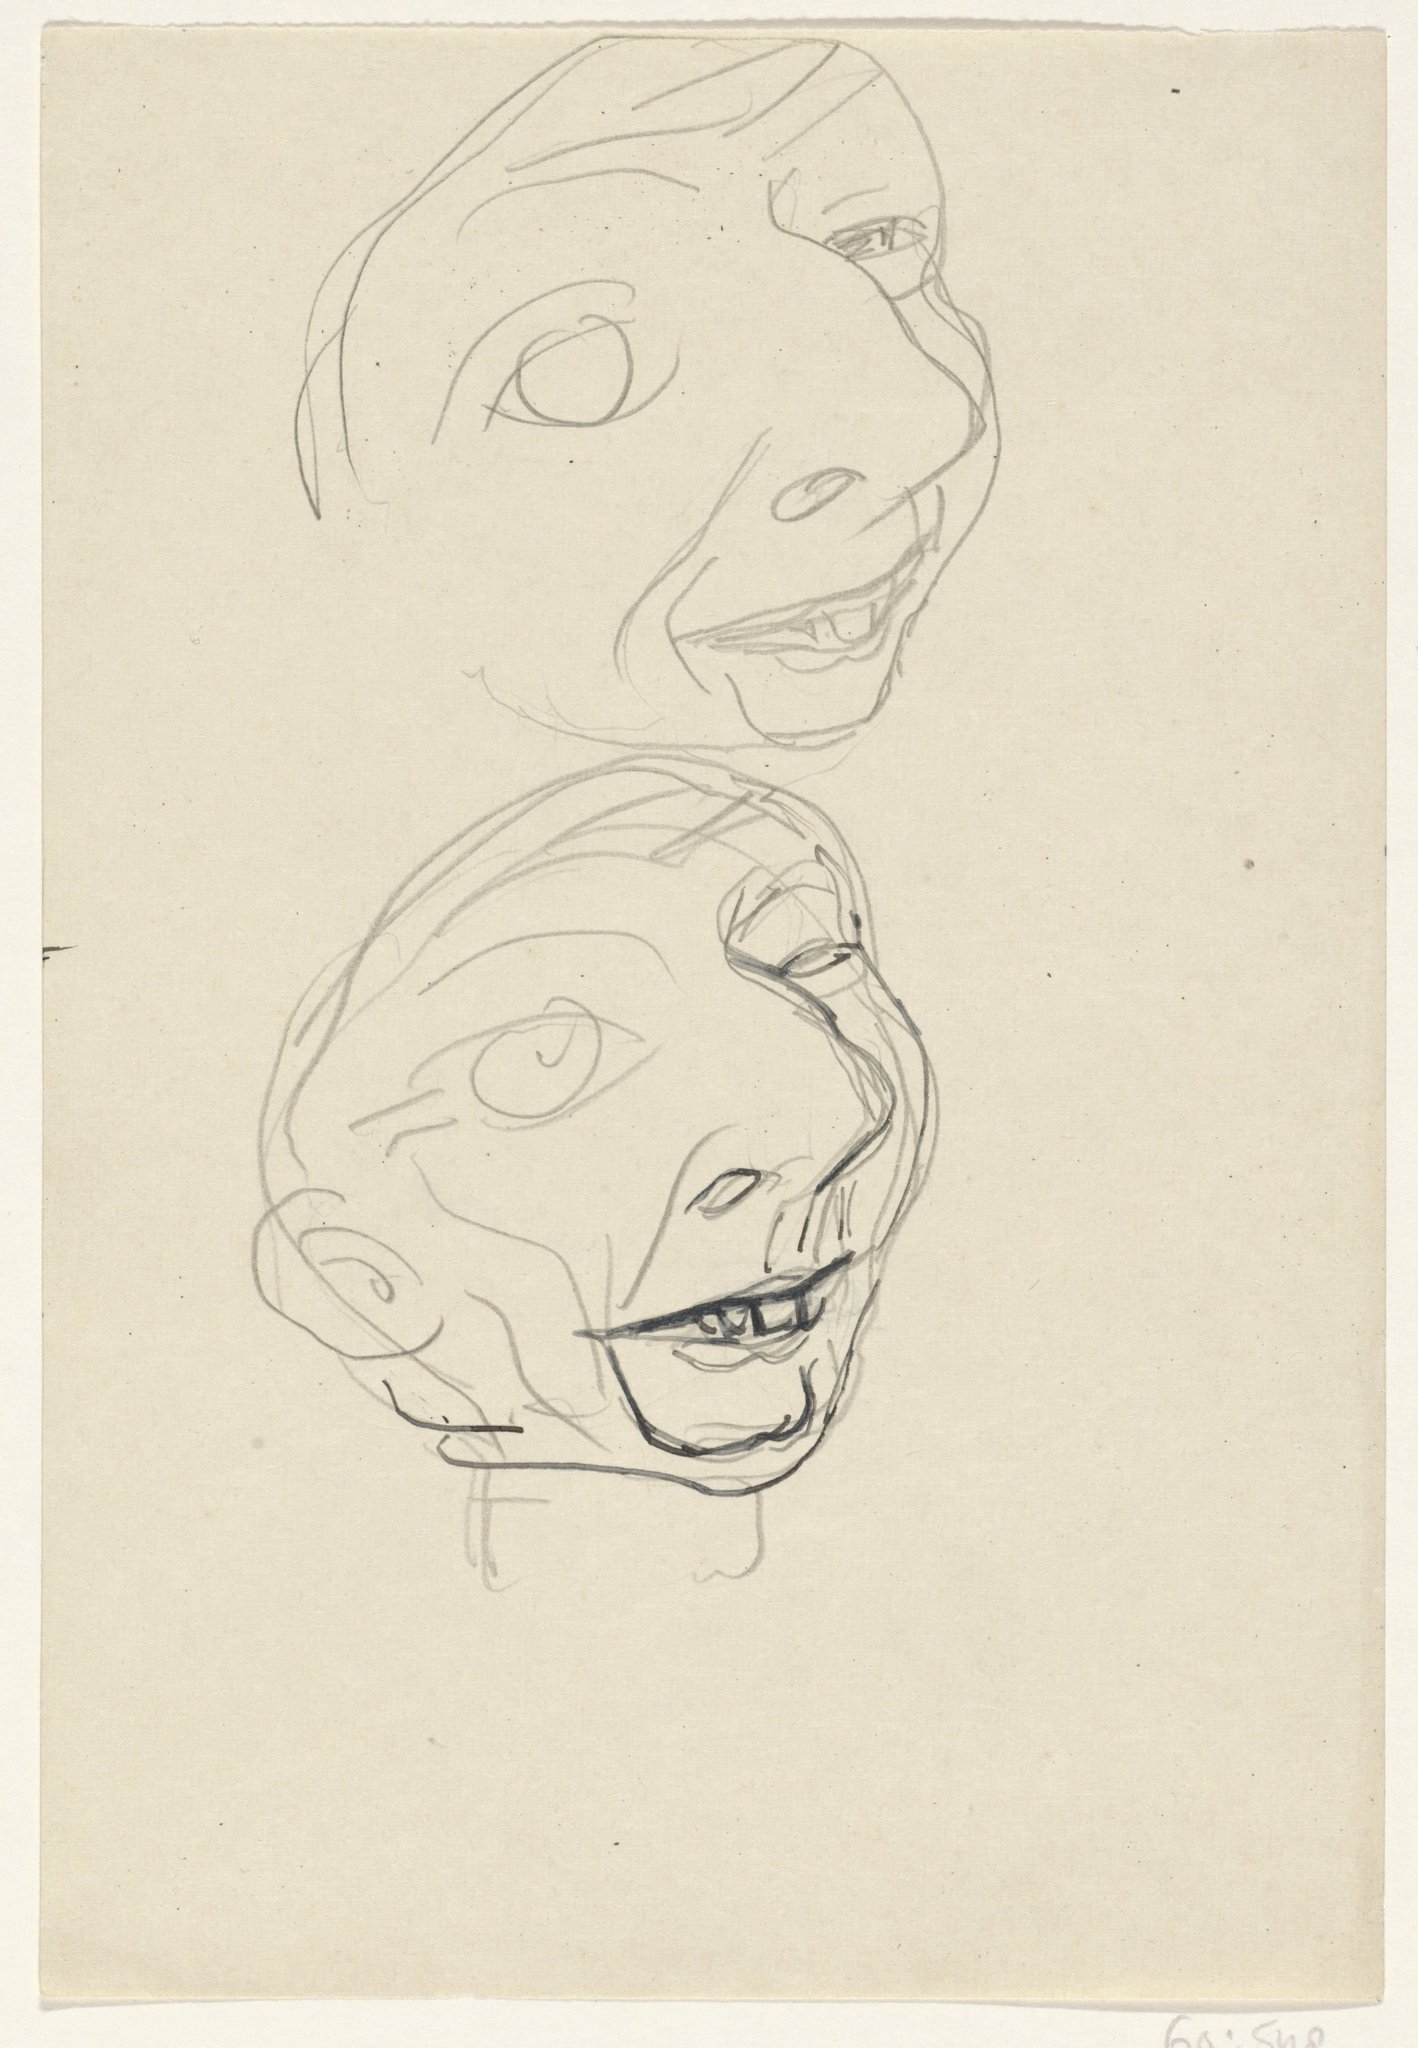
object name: drawing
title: Karikatuur van Leo Gestel op zijn ziekbed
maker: leo gestel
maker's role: draughtsman, print maker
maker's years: 1881-1941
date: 1911-1941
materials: ink, paper, pencil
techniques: pen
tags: print maker, draughtsman, leo gestel, sick-bed, historical persons, portrait, self-portrait of artist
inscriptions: collector's mark: Lugt 2228